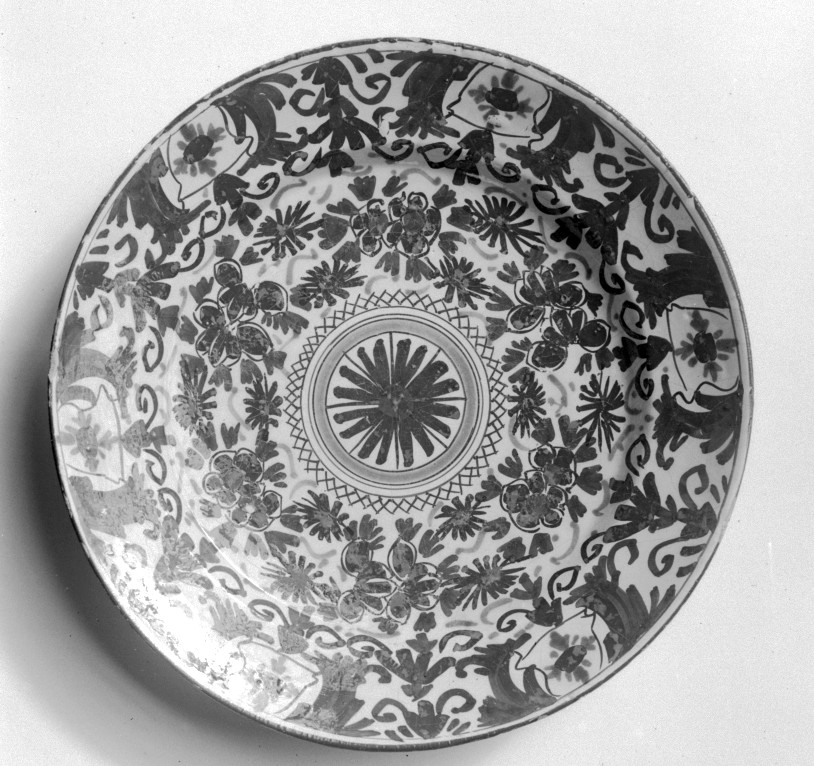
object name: dish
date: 1801-1900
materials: pottery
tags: flowers